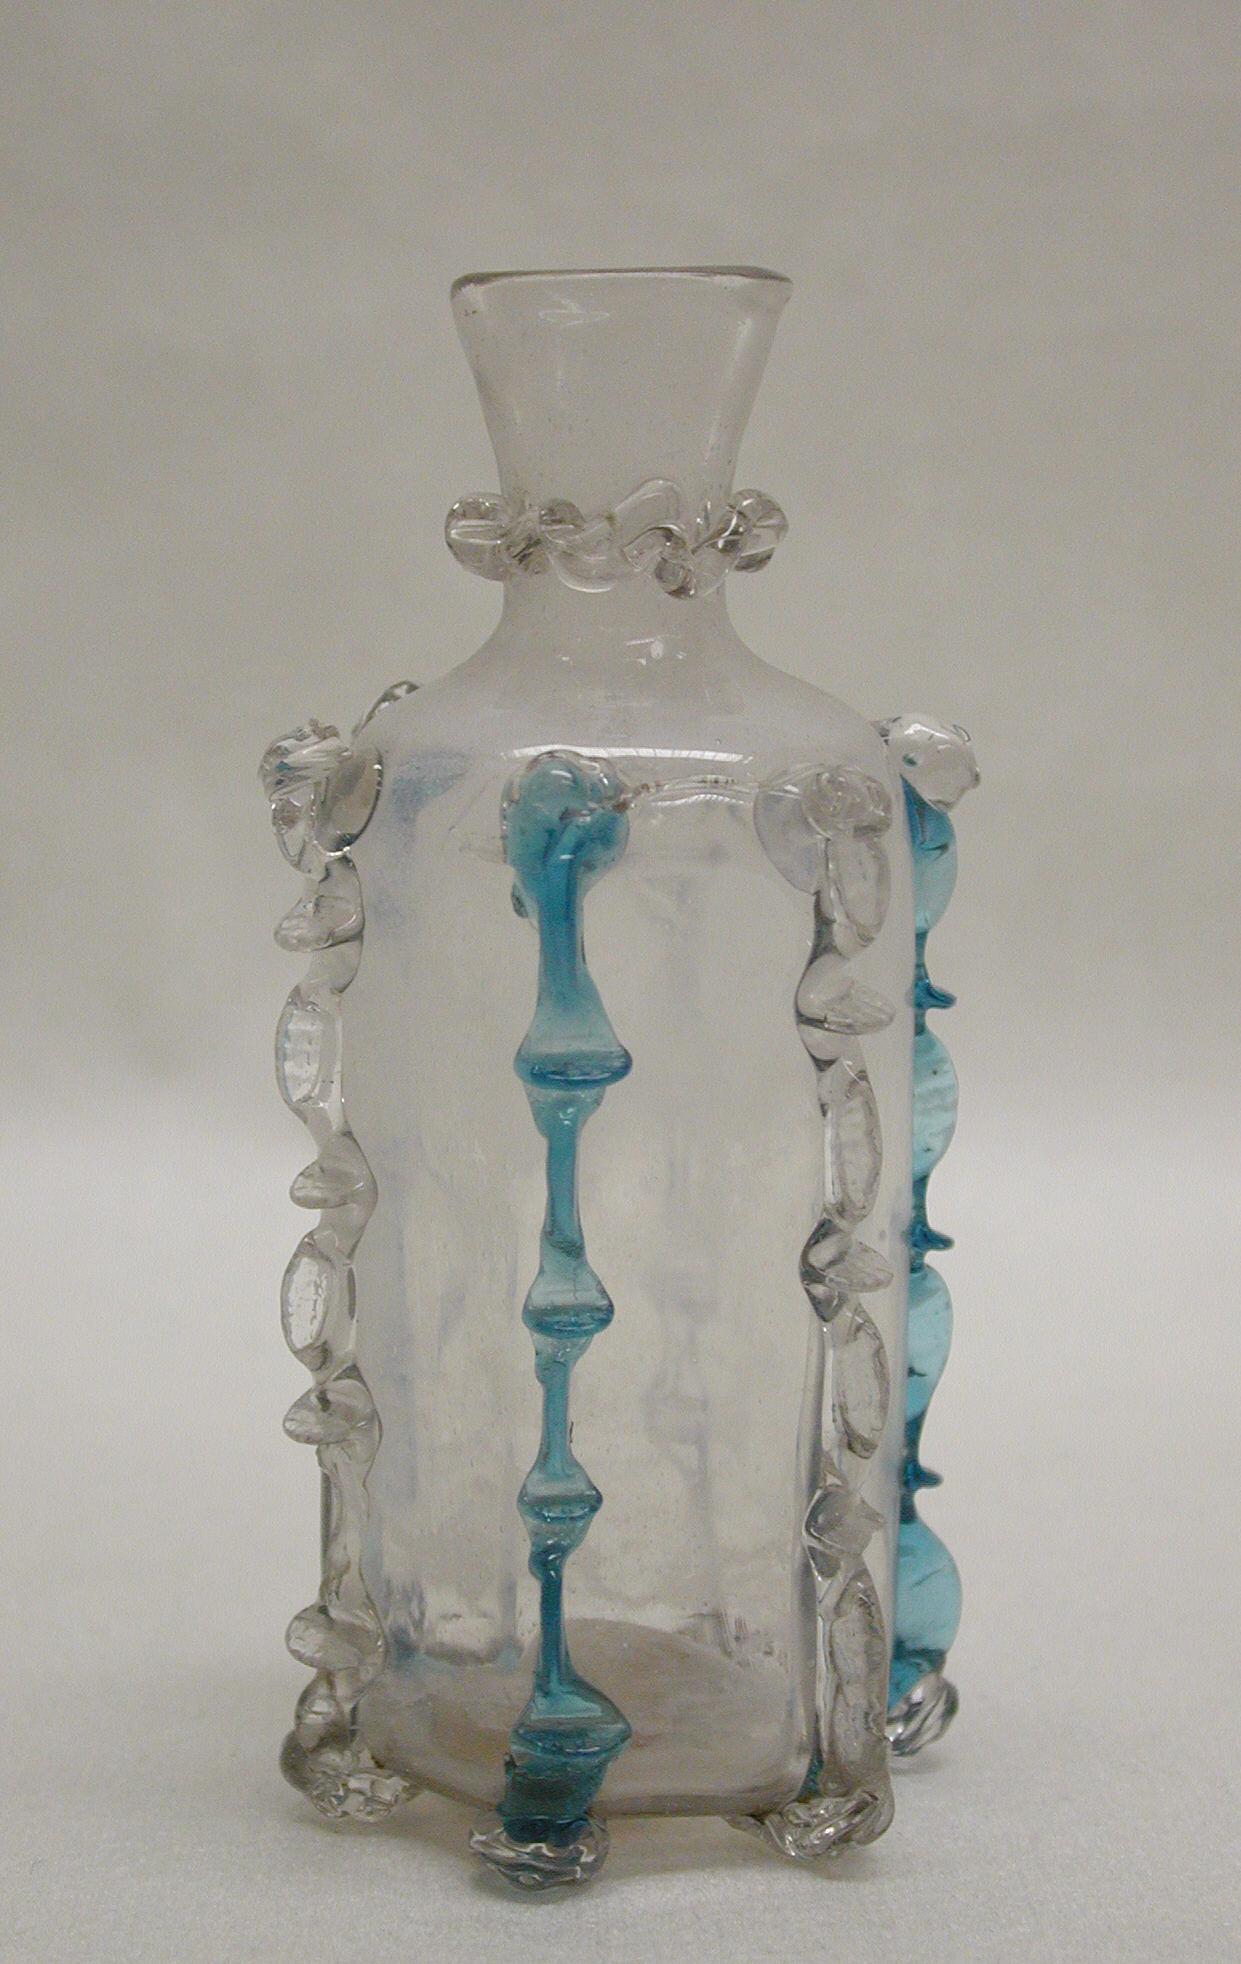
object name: bottle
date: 1667-1733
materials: glass